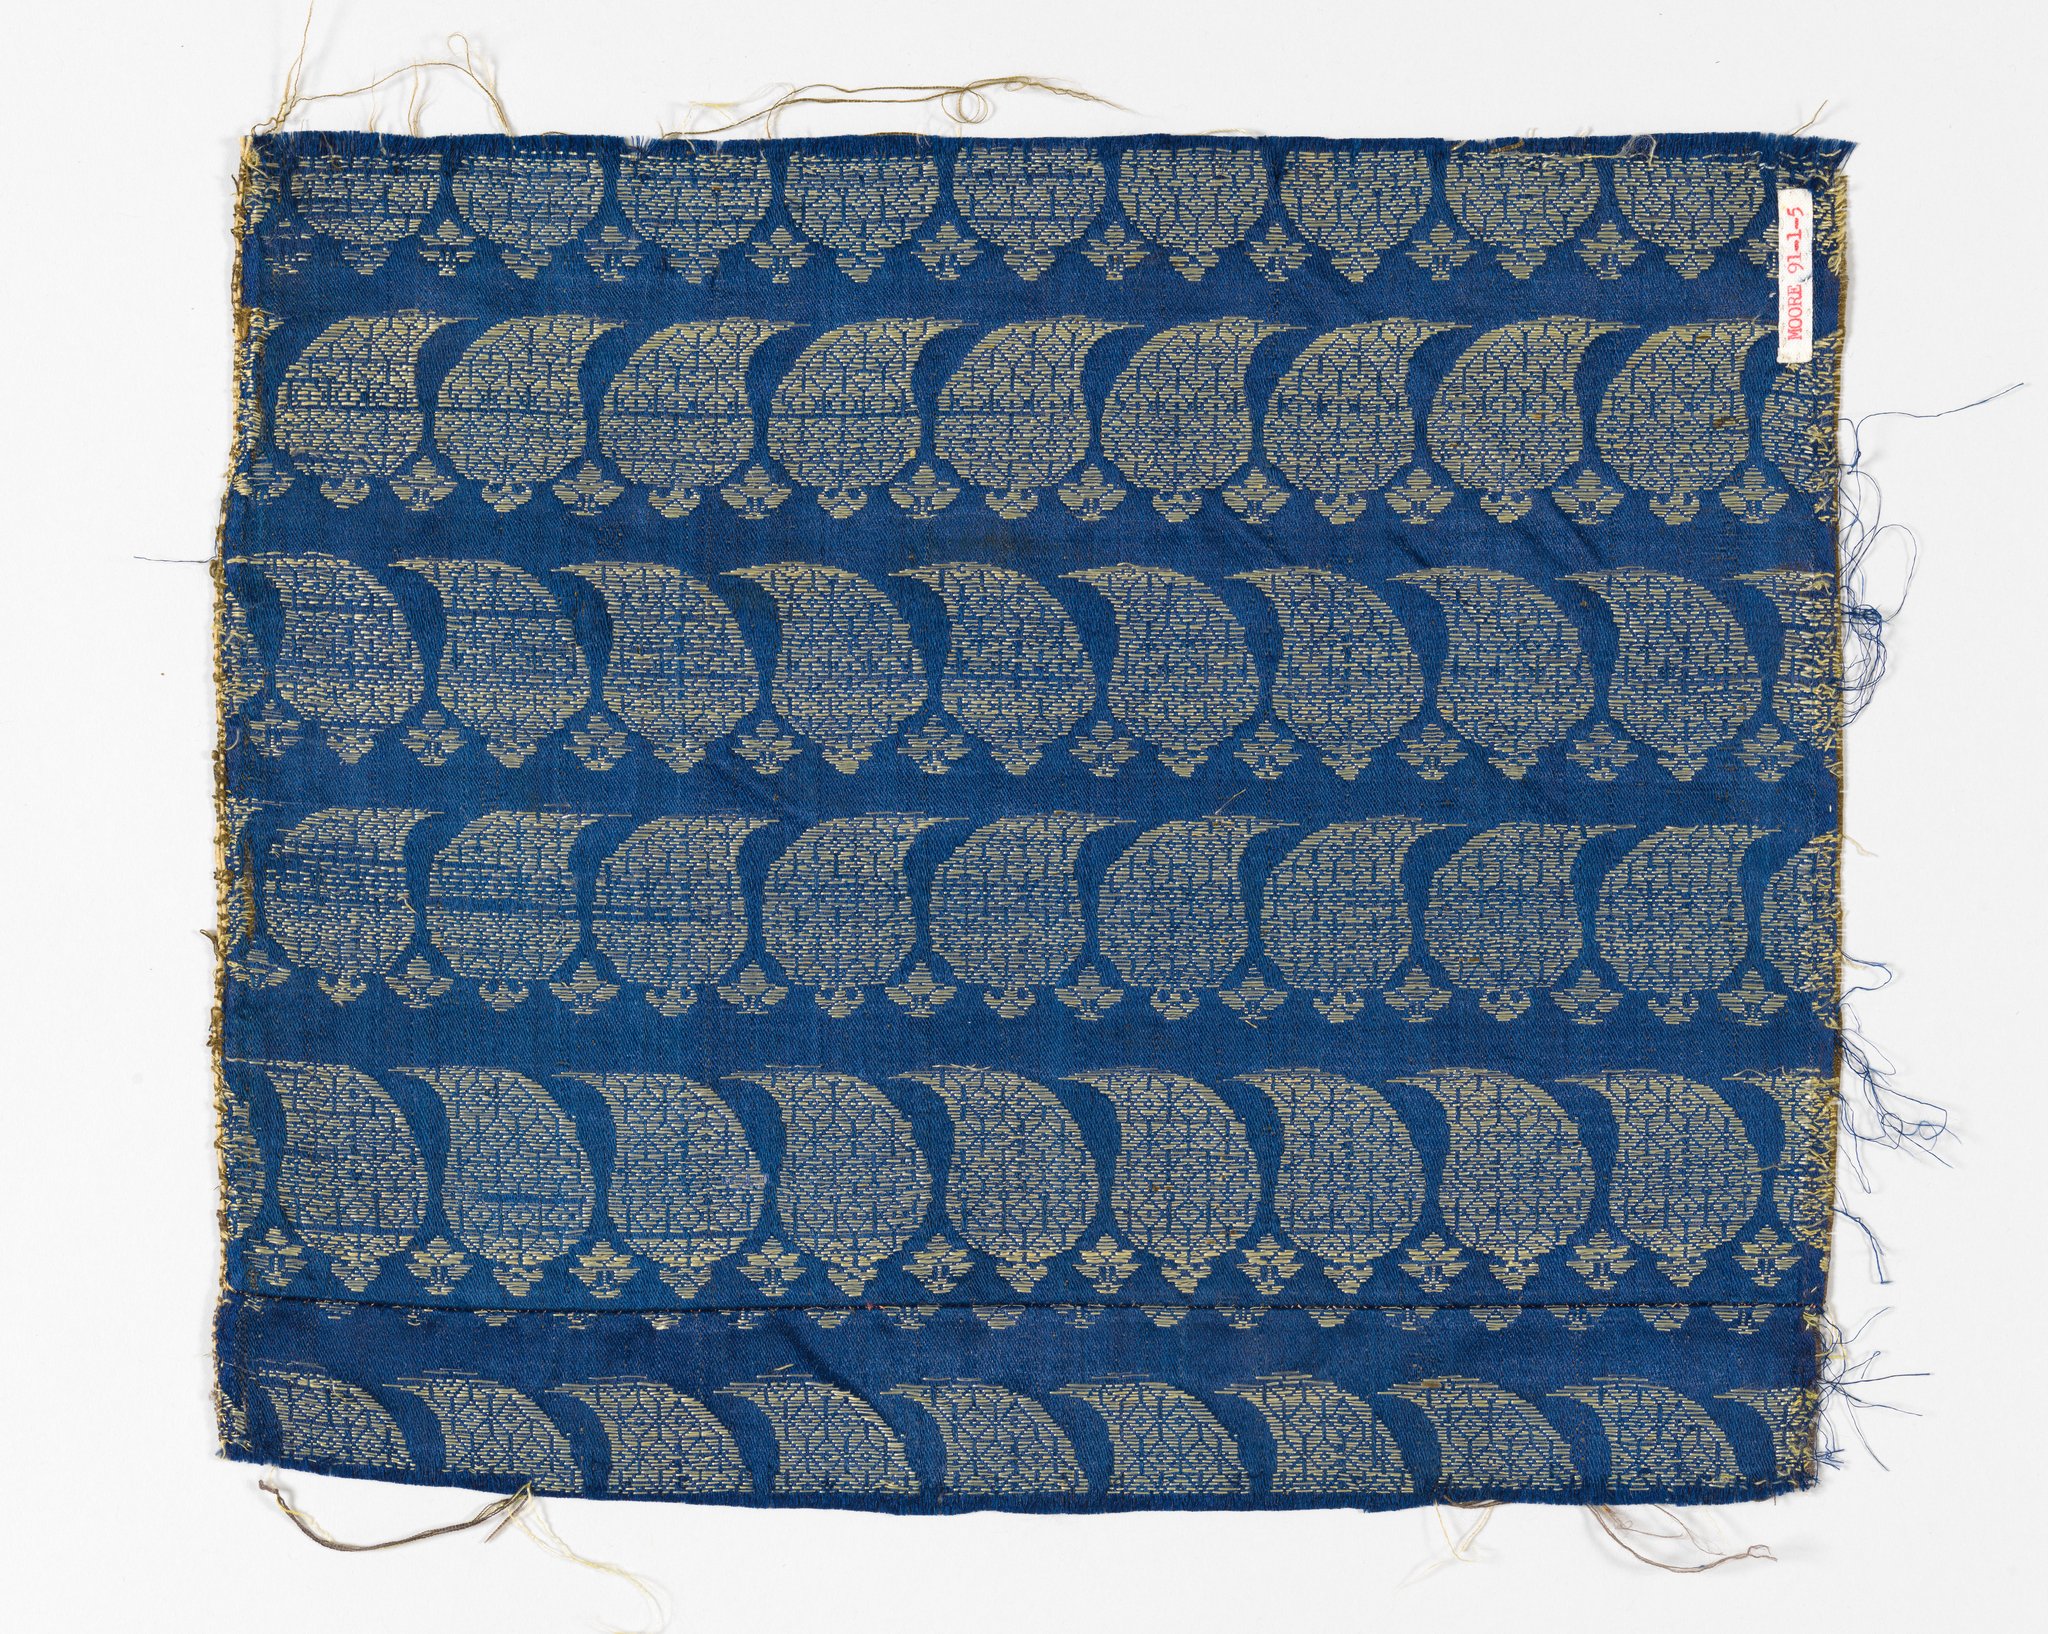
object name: textile fragment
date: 1701-1900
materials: silk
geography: india